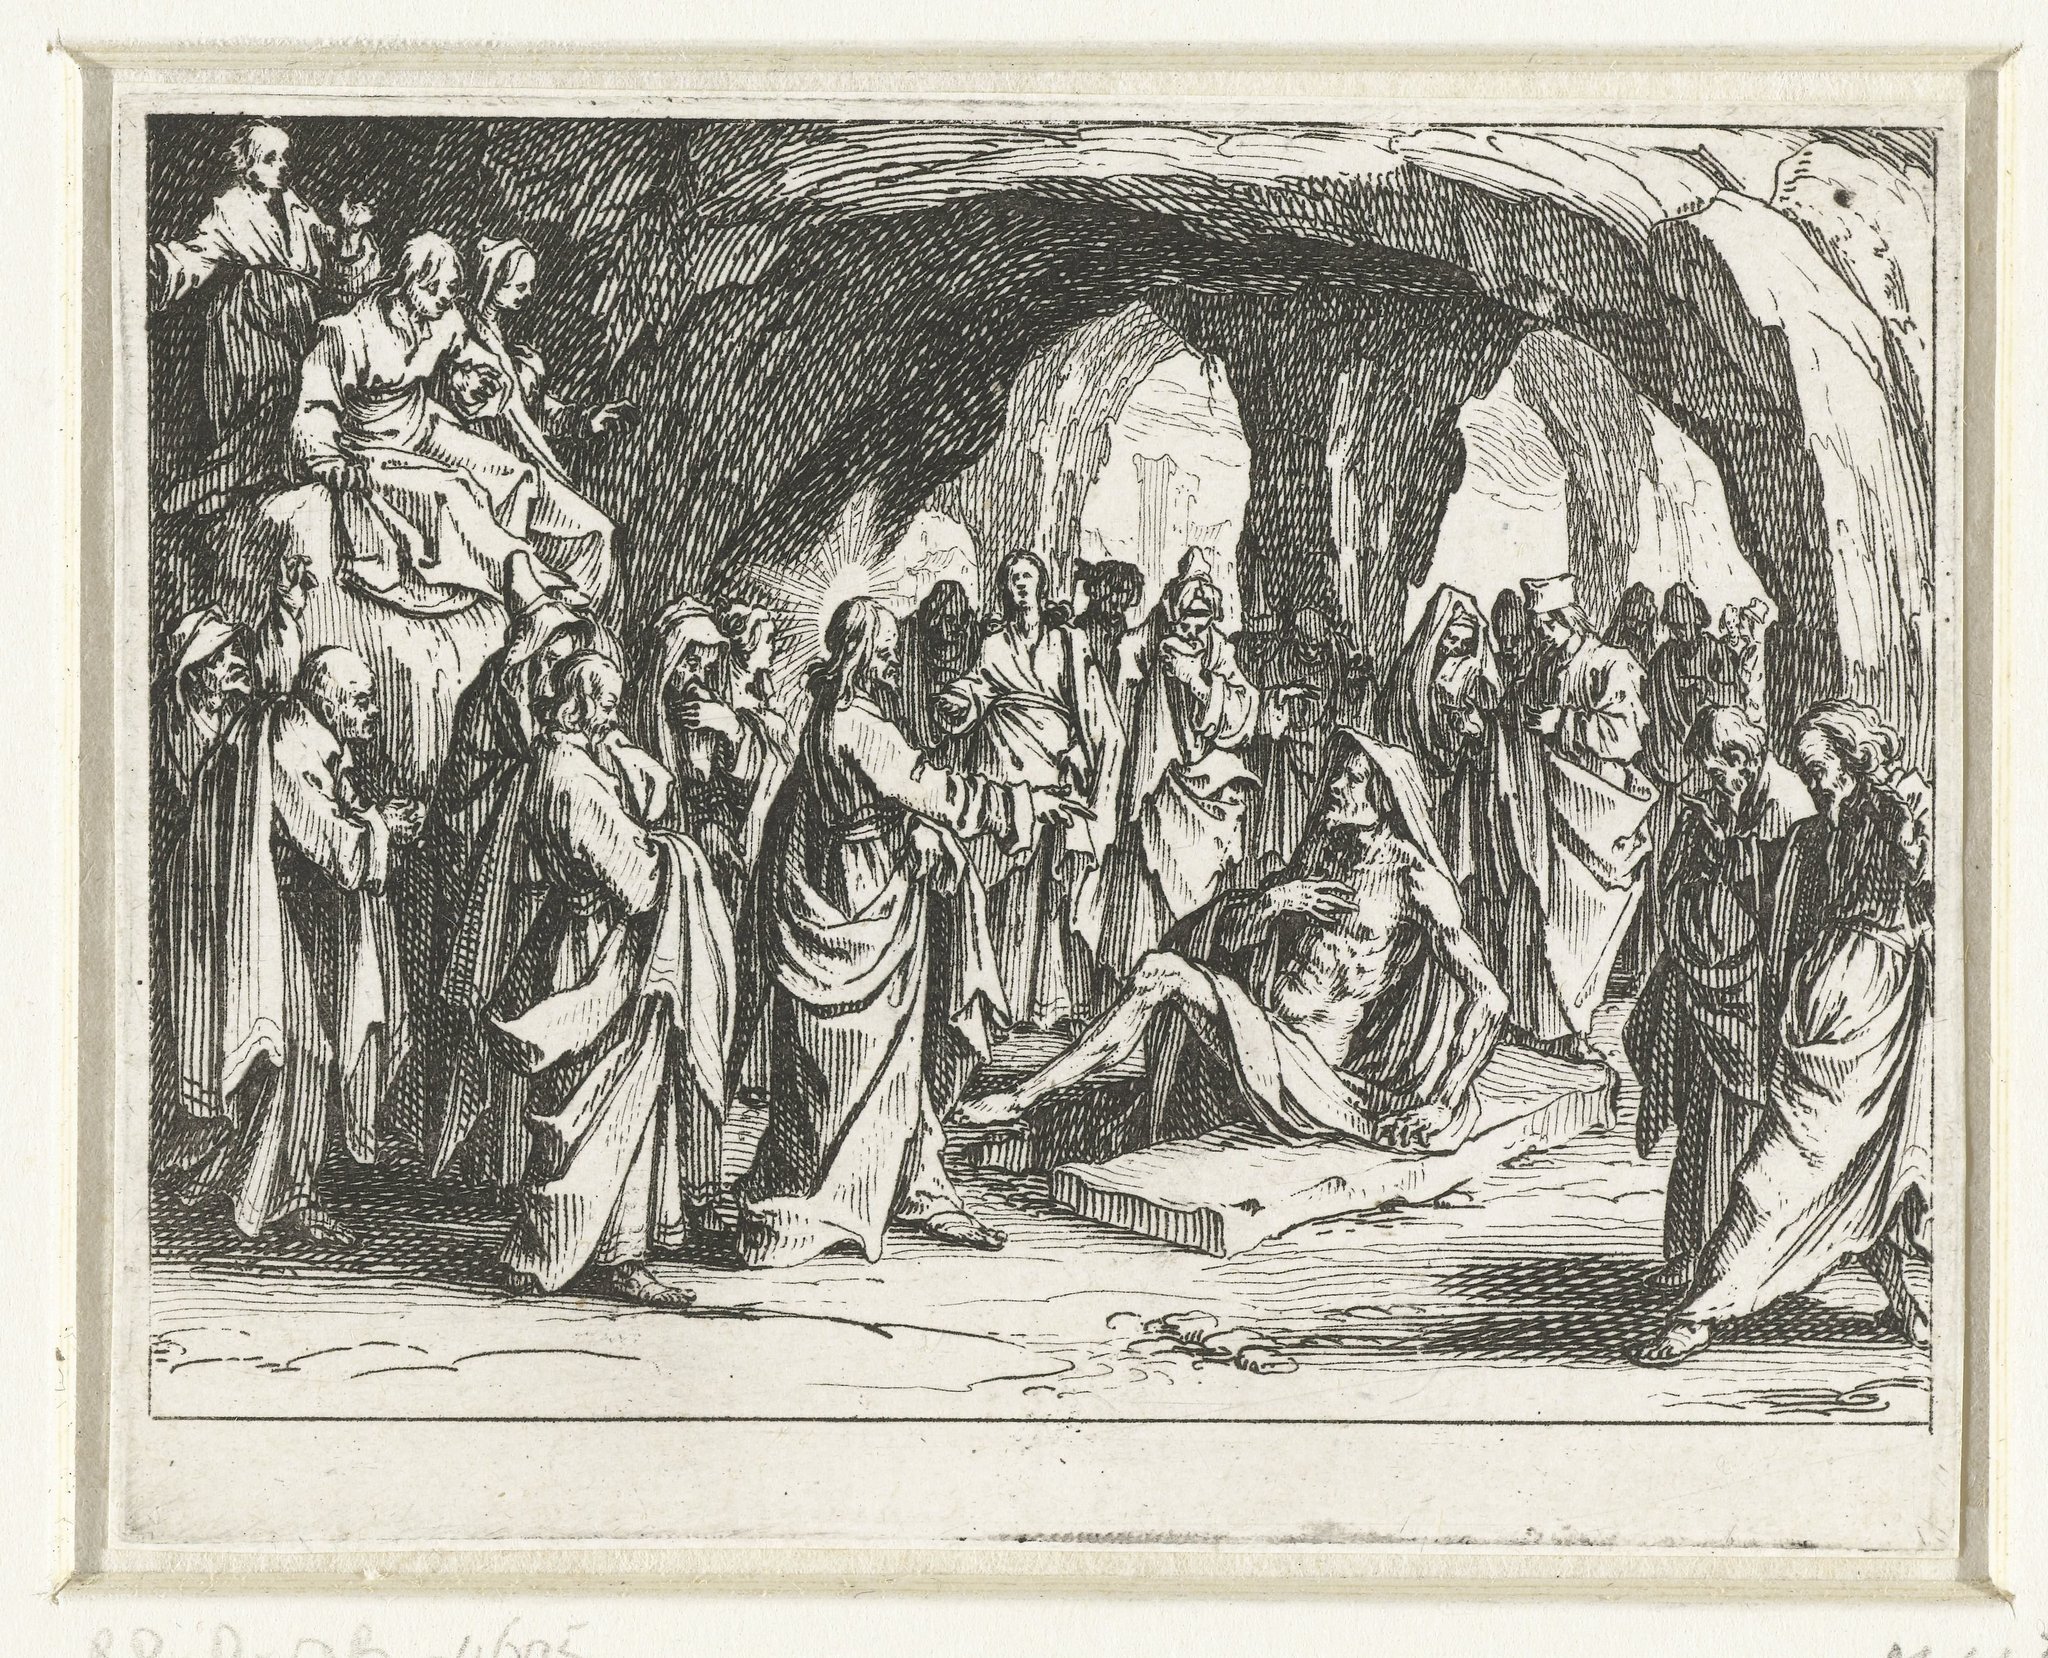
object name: print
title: Scènes uit het Nieuwe Testament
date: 1635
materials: paper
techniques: etching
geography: paris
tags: the raising of lazarus ('lazarus, come out')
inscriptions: collector's mark: Lugt 240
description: Christus staat, omringd door een grote groep mensen, in een grot bij een graf, waaruit een man opstaat (Lazarus). Deze prent is onderdeel van een reeks van tien prenten met voorstellingen uit het Nieuwe Testament, waaraan na Callots dood een titelprent is toegevoegd.